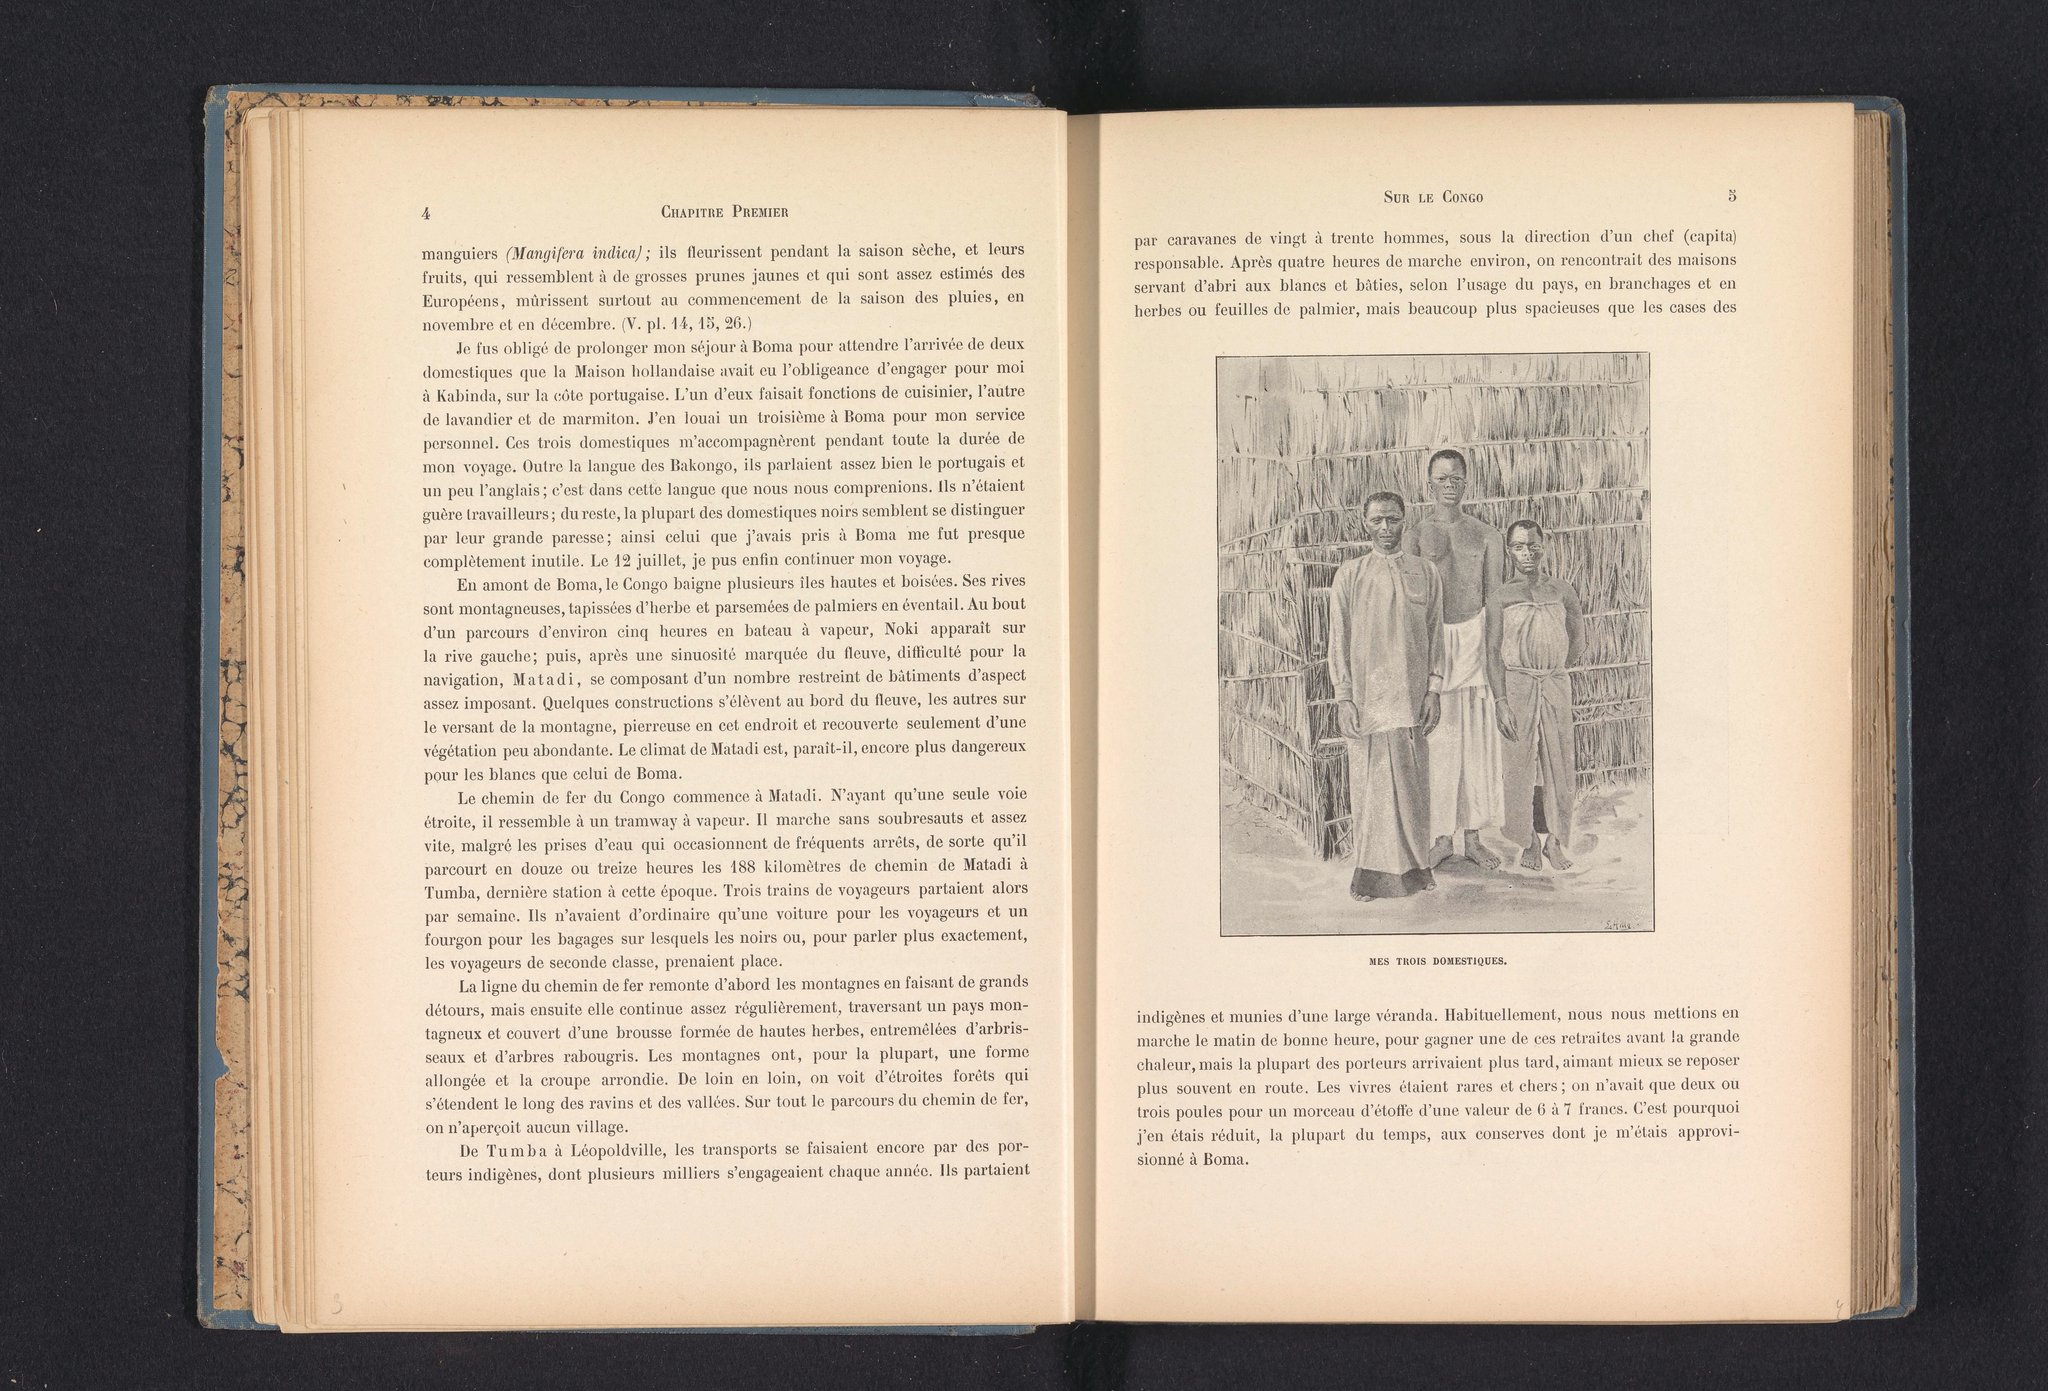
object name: photomechanical print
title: Mes trois domestiques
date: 1896-1899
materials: paper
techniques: autotype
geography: congo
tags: house personnel, servants